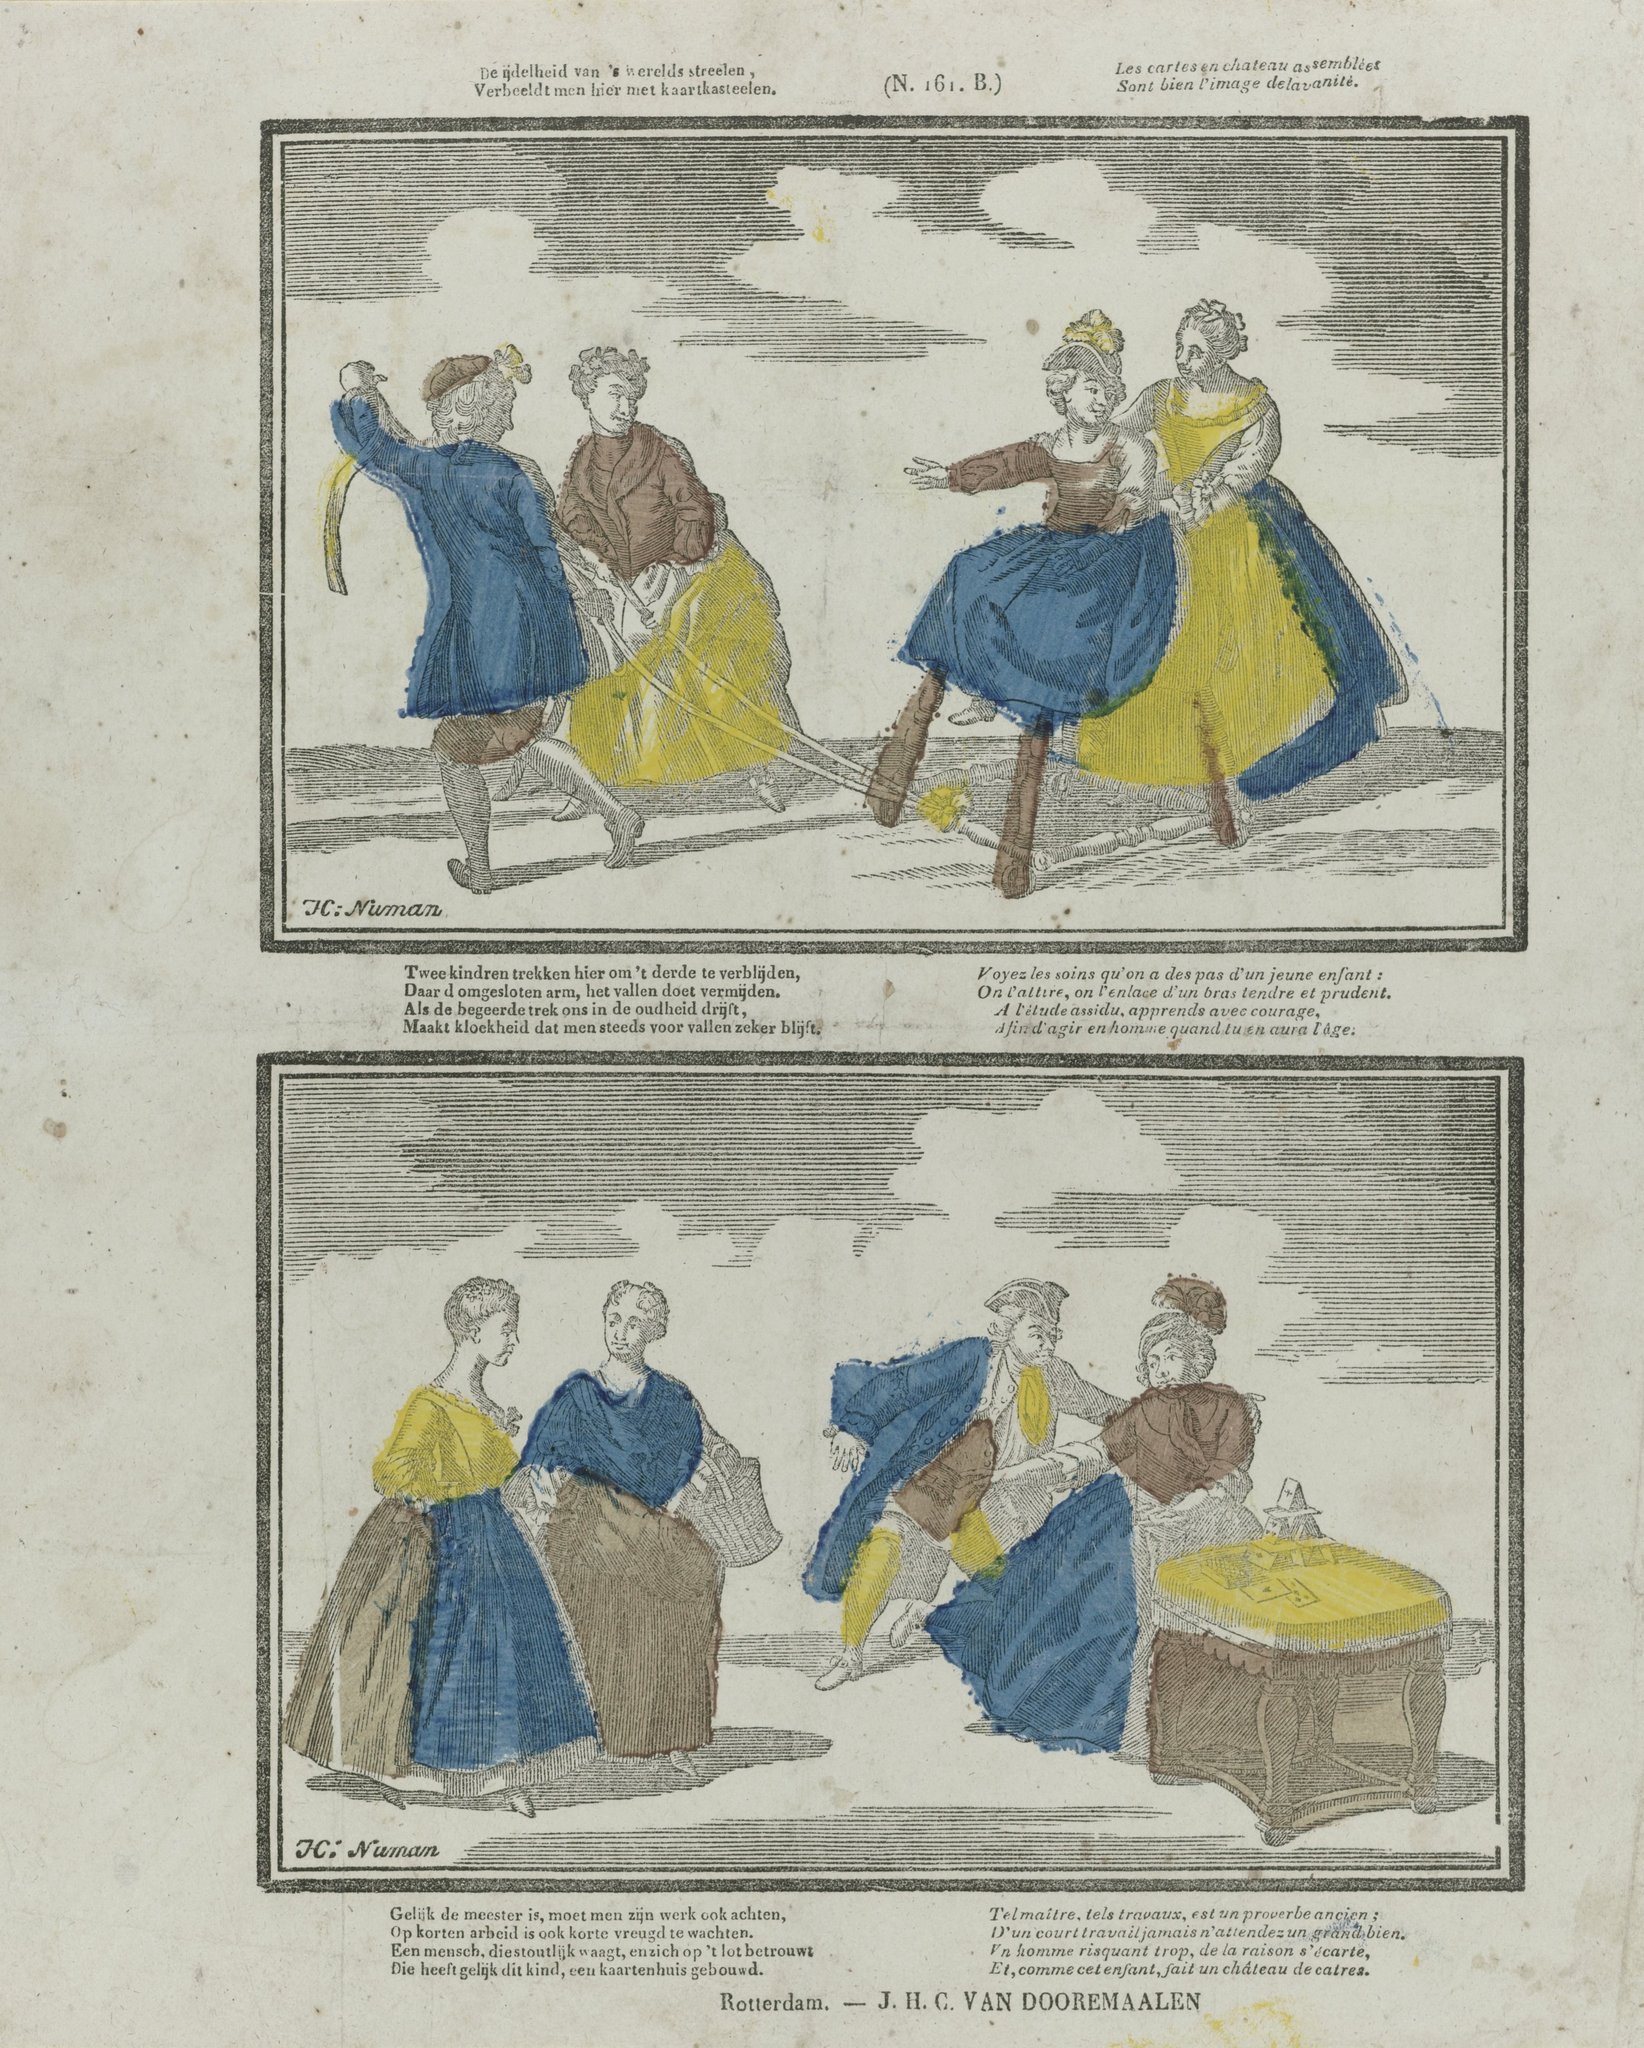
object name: popular print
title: De ijdelheid van 's werelds streelen, / Verbeeldt men hier met kaartkasteelen / Les cartes en chateau assemblées / Sant bien l´image delavanité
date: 1800-1833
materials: paper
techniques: colour, letterpress printing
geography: rotterdam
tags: children's games and plays, playing-cards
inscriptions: collector's mark: Lugt 2760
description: Blad met 2 voorstellingen van spelende kinderen. Boven trekken twee kinderen een meid op een kar vooruit. Onder bouwt een meid een kaartenhuis. Onder elke afbeelding een vierregelig vers in het Nederlands en in het Frans. Genummerd midden boven: (N. 161. B.).